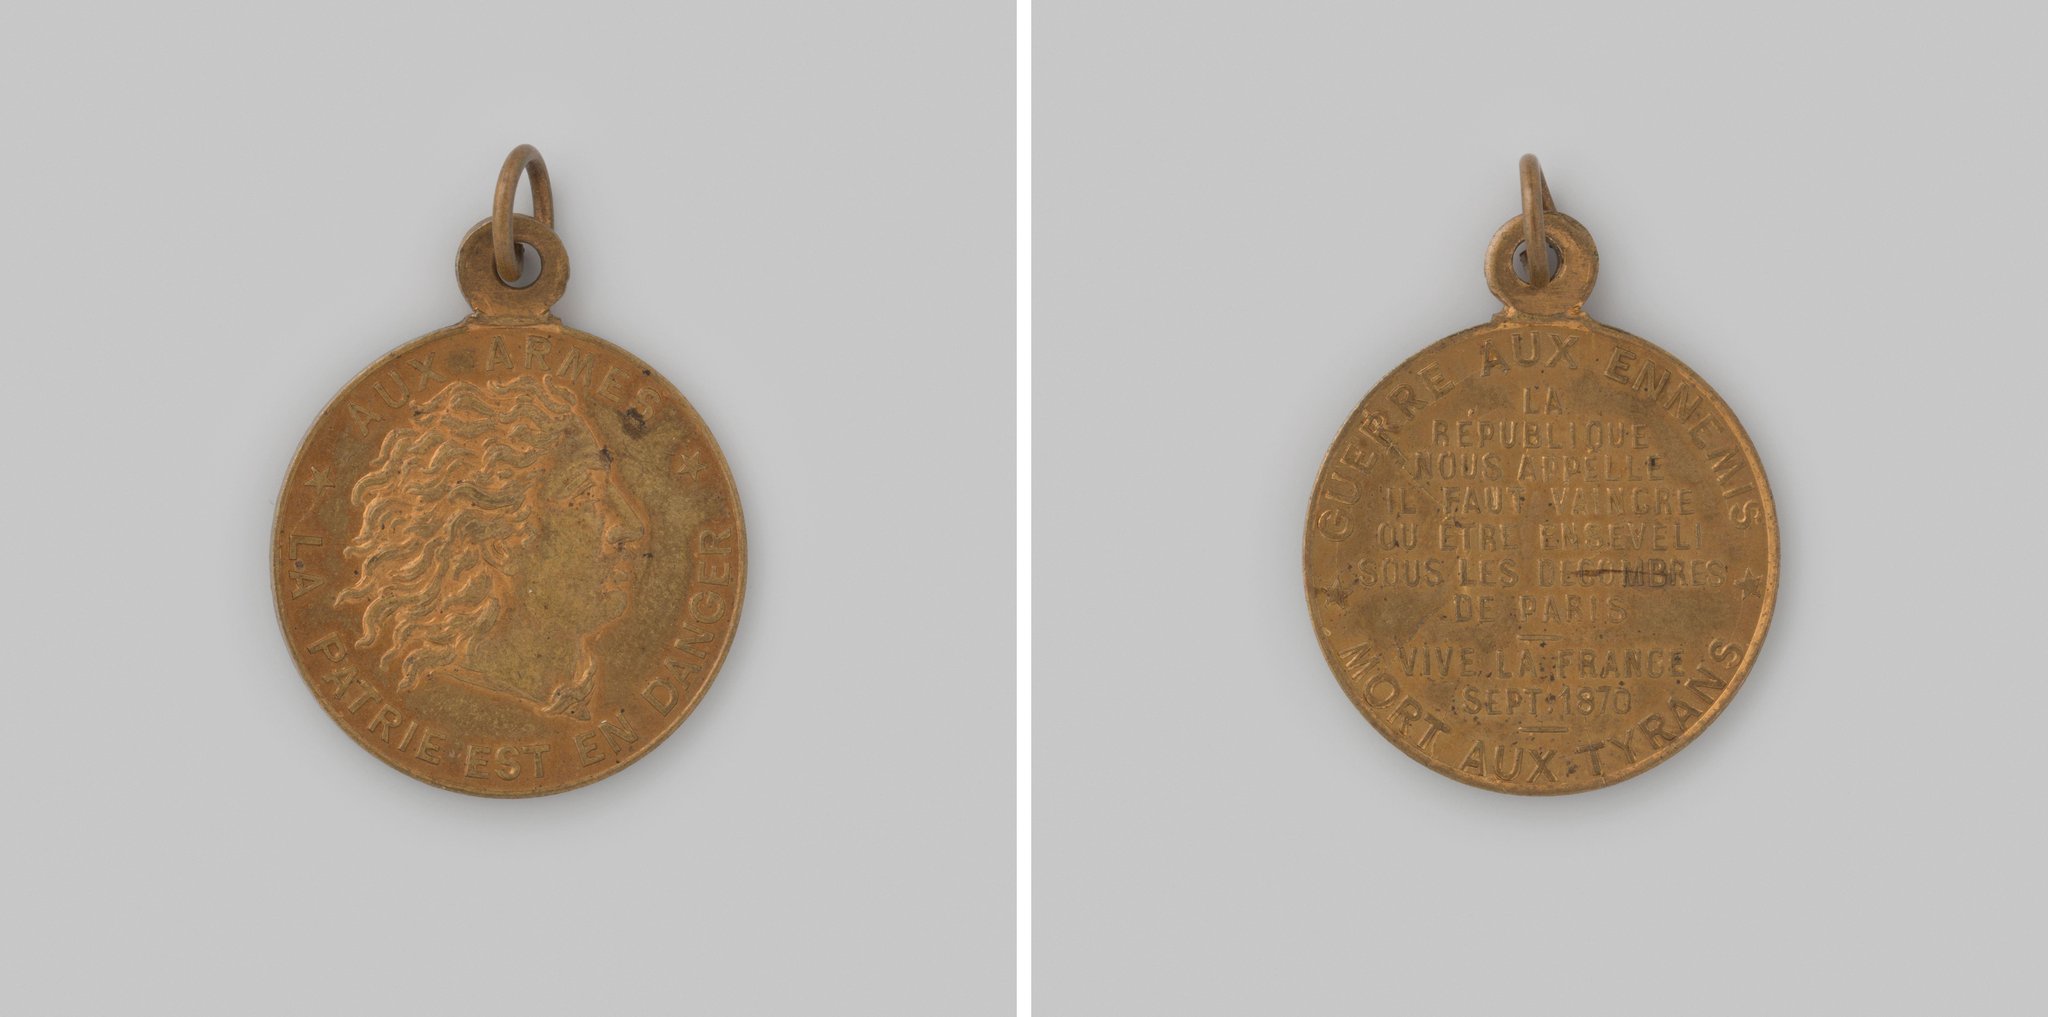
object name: history medal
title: Frankrijk in oorlog met Pruisen 1870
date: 1870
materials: brass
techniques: striking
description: Messing penning met oog en draagring, op de voorzijde een vrouwenportret naar rechts met omschrift, op de keerzijde negen regels tekst met omschrift.